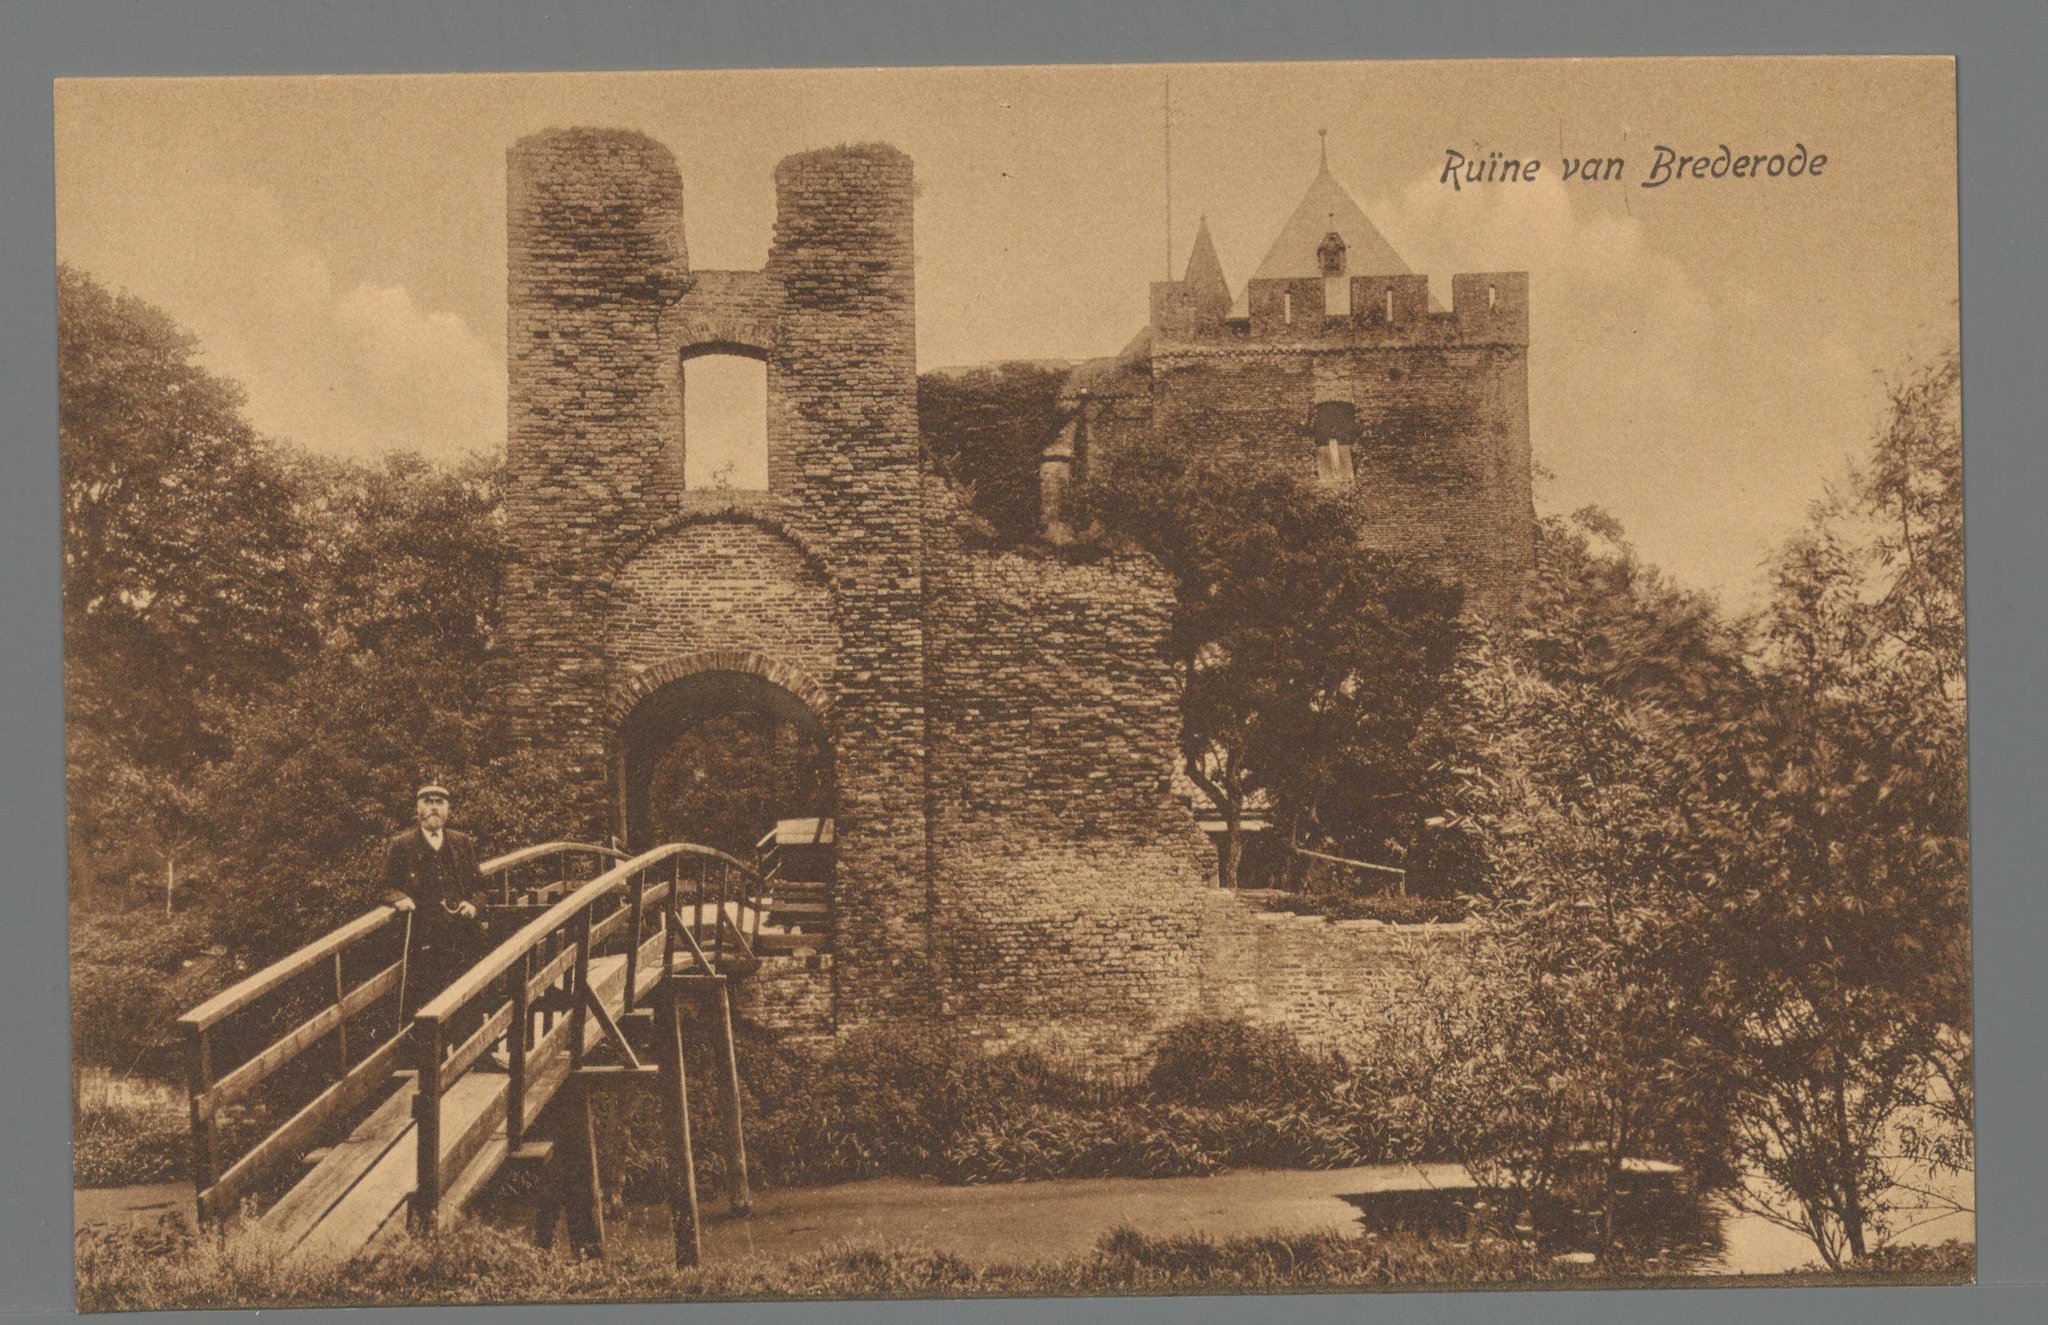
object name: photomechanical print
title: Ruïne van Brederode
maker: Anonymous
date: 1913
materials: cardboard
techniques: photograph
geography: santpoort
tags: castle, bridge in city across river, canal, etc.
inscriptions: date